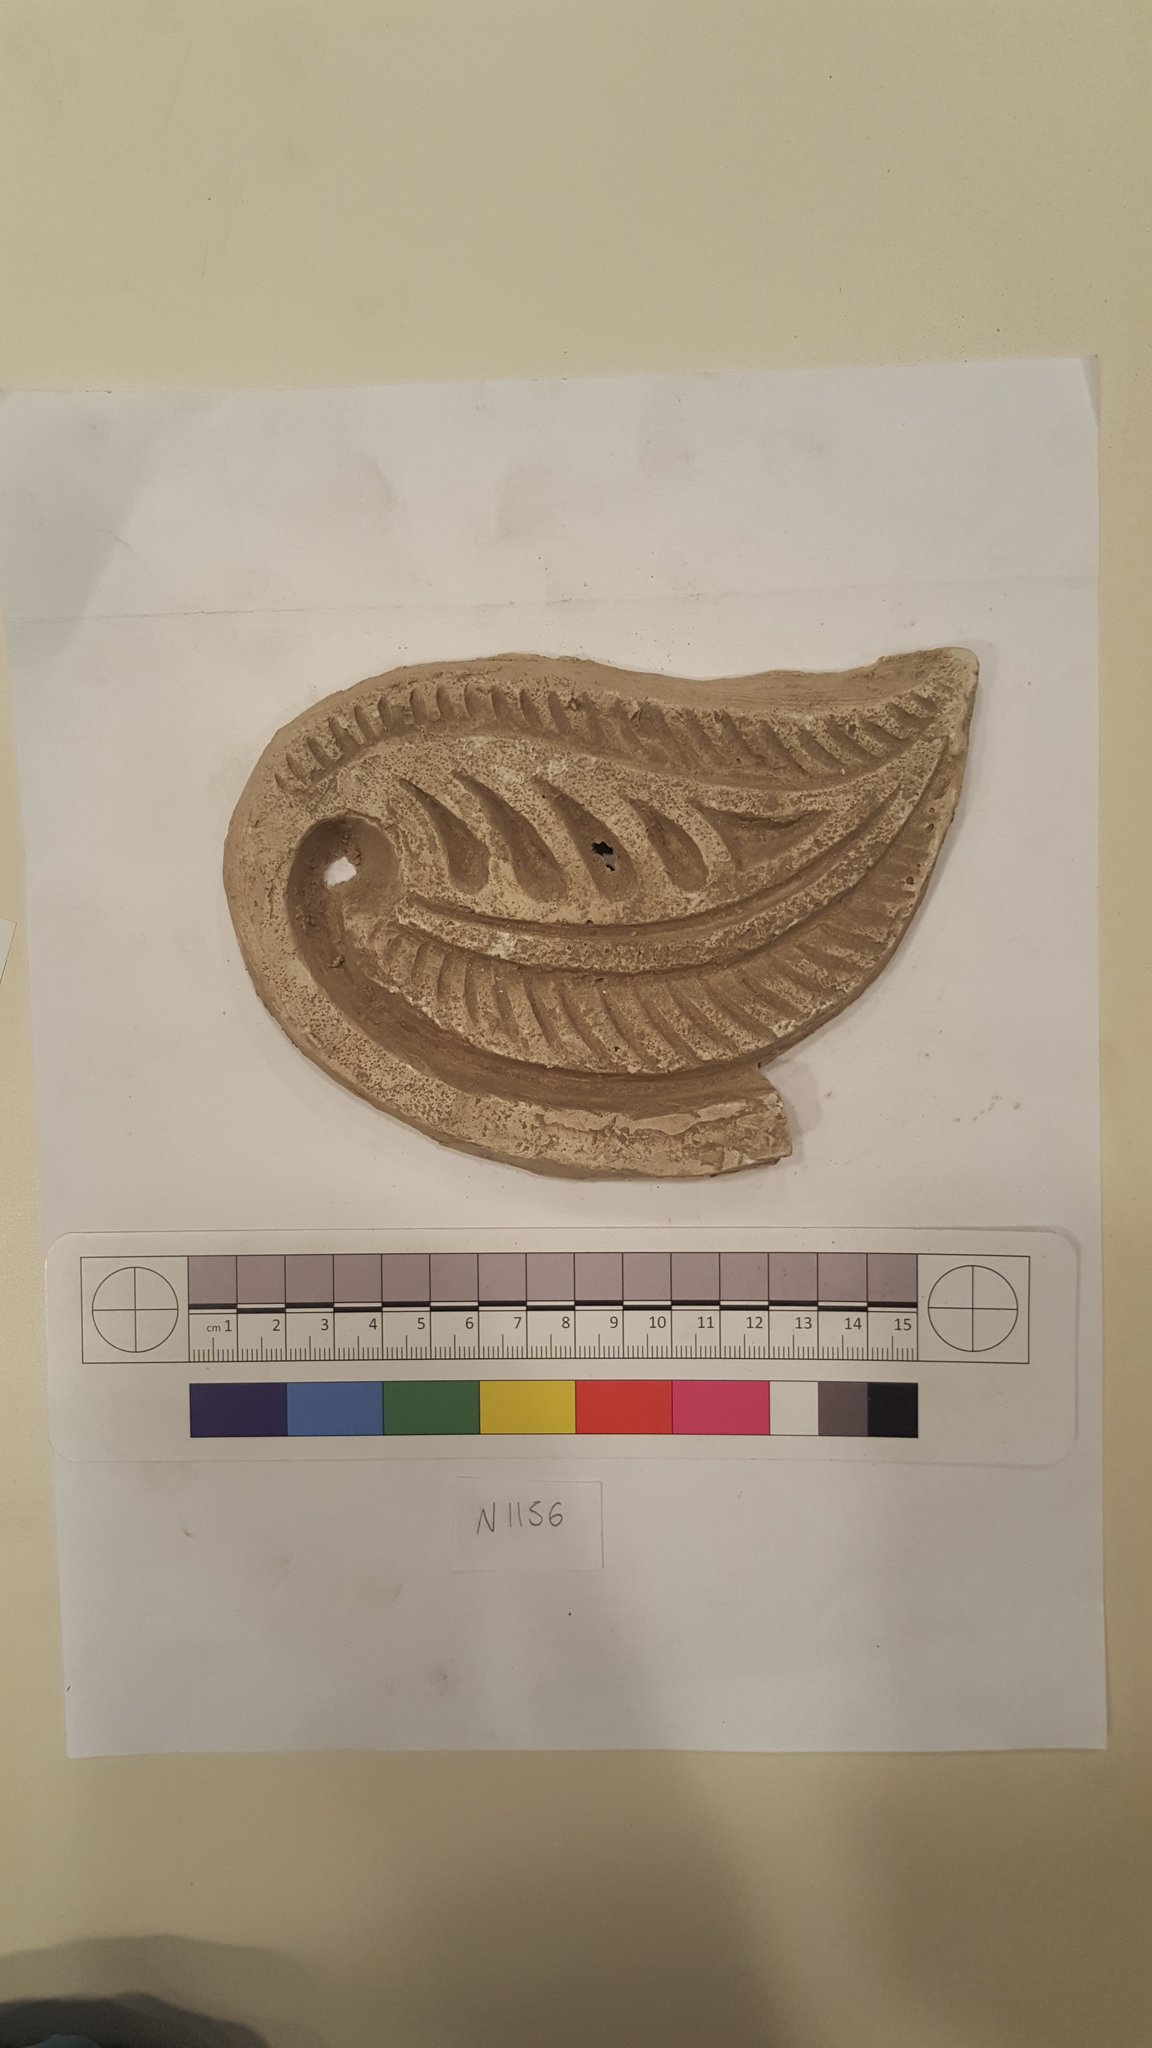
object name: fragment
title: Stucco Fragment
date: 701-1200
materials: gypsum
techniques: carving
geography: iran